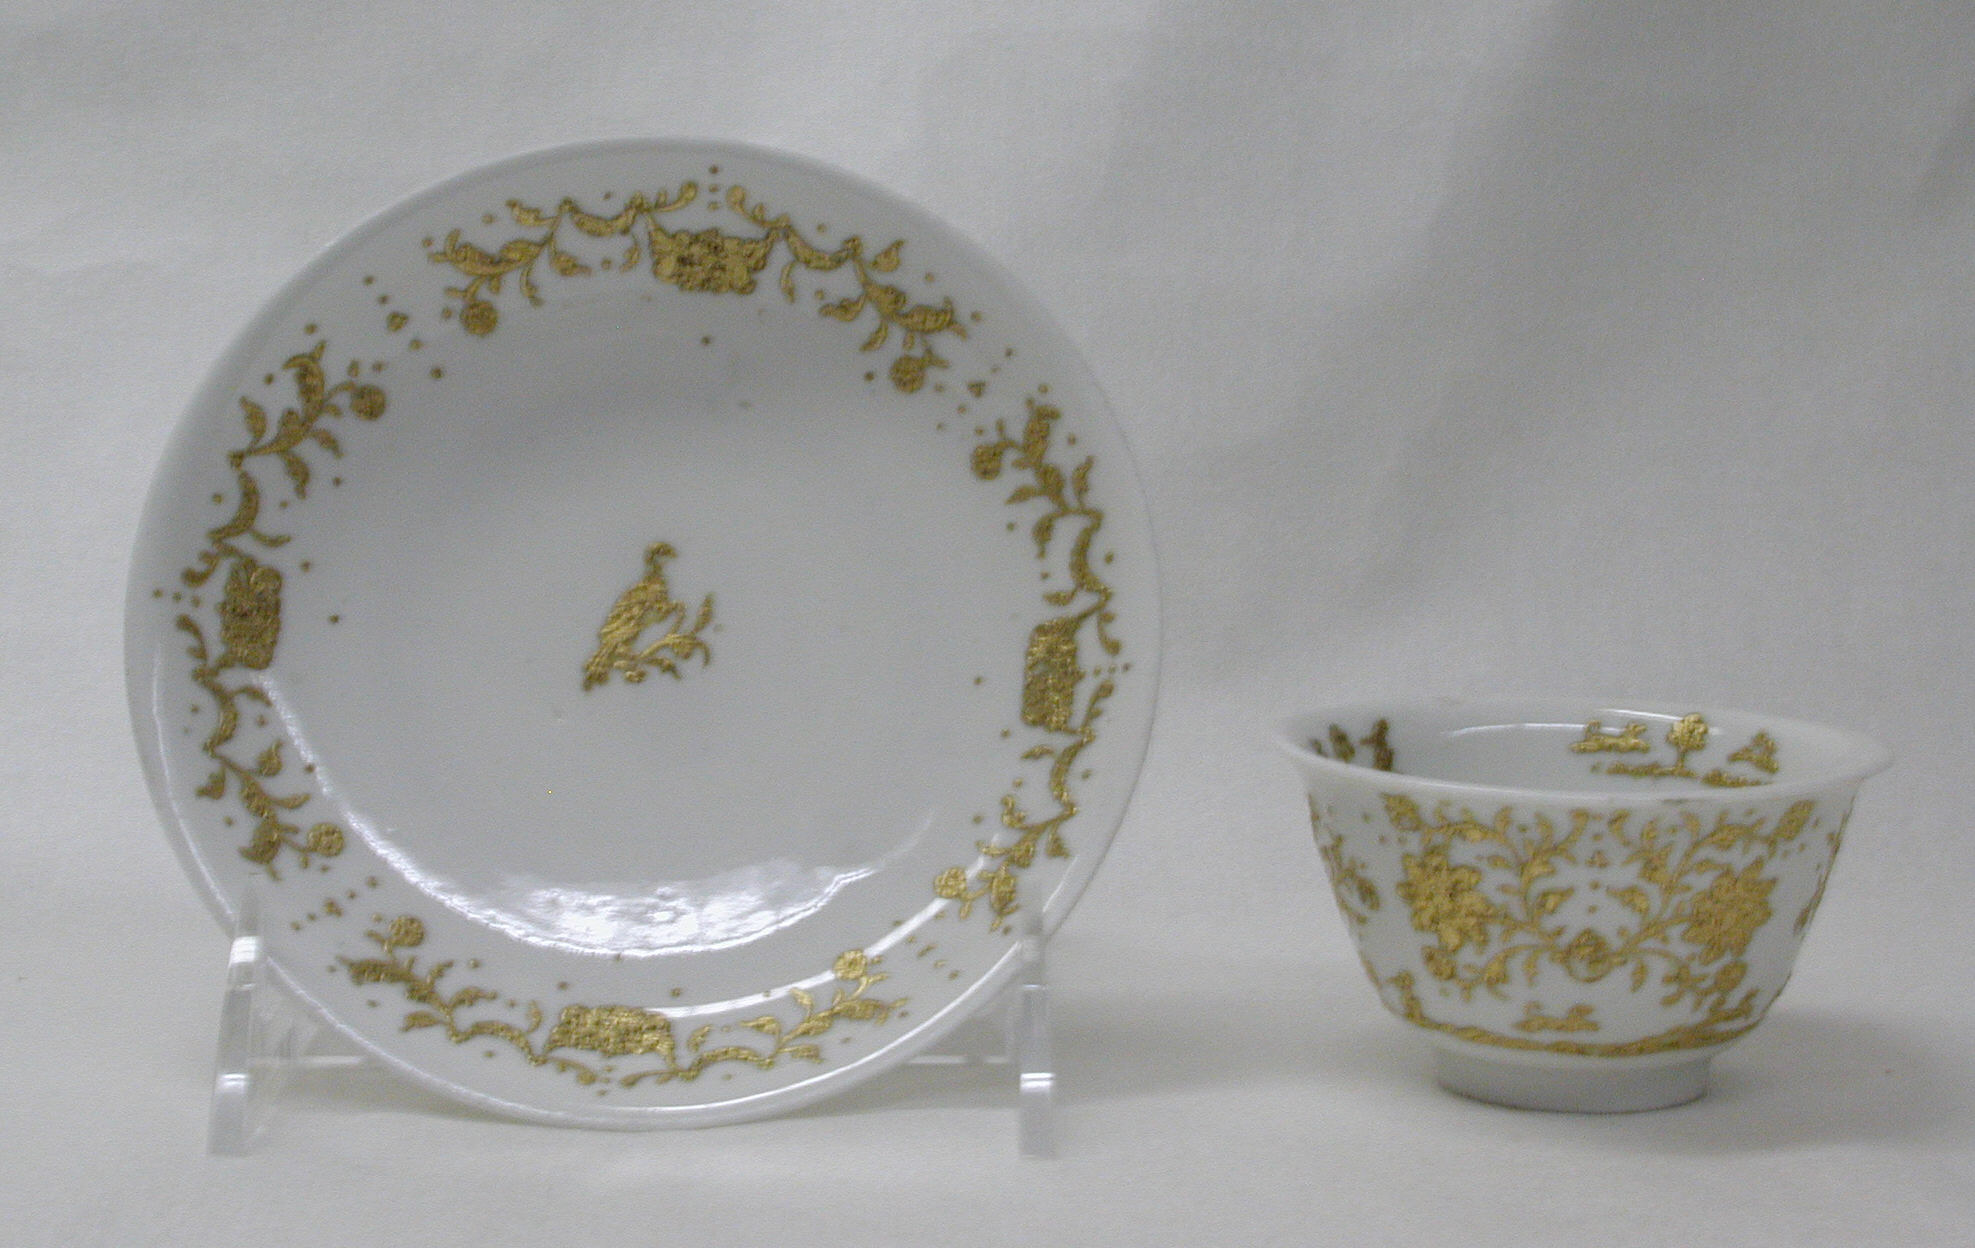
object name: teacup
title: Teacup (1 of 6) (part of a service)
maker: meissen manufactory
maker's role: manufactory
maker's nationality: german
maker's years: 1710-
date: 1720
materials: hard paste porcelain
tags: flowers